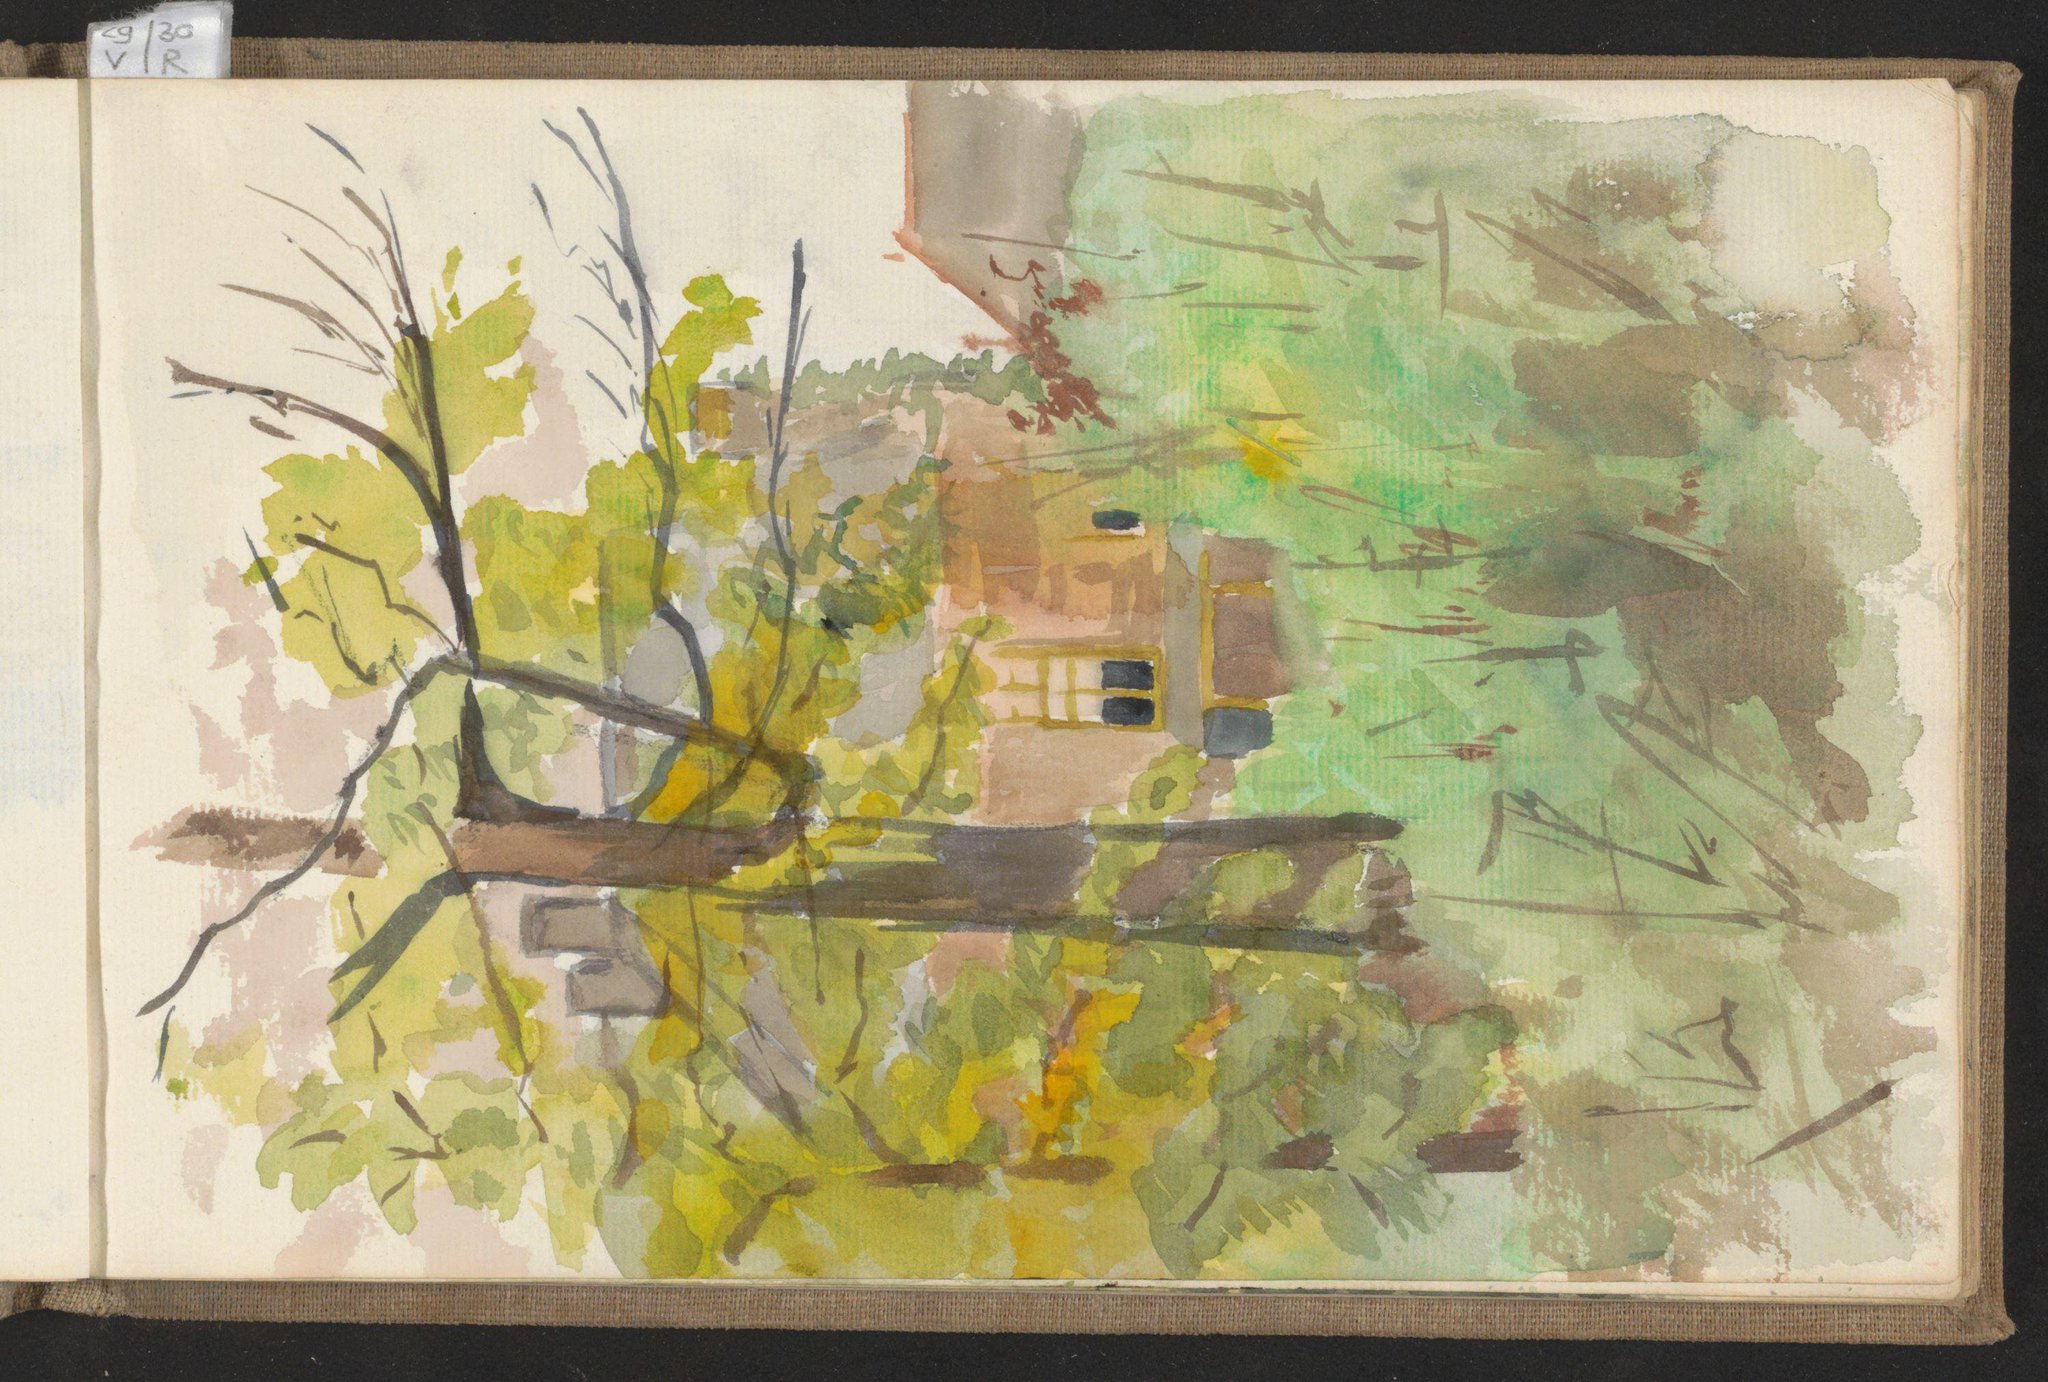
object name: sketchbook leaf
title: Huizen tussen de bomen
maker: jonkheer johannes ludovicus paulus bosch van drakestein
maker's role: draughtsman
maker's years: 1865-1929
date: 1896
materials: paper, pencil, watercolor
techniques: brush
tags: trees, the usual house or row of houses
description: Blad 27 recto uit een schetsboek met 58 bladen.